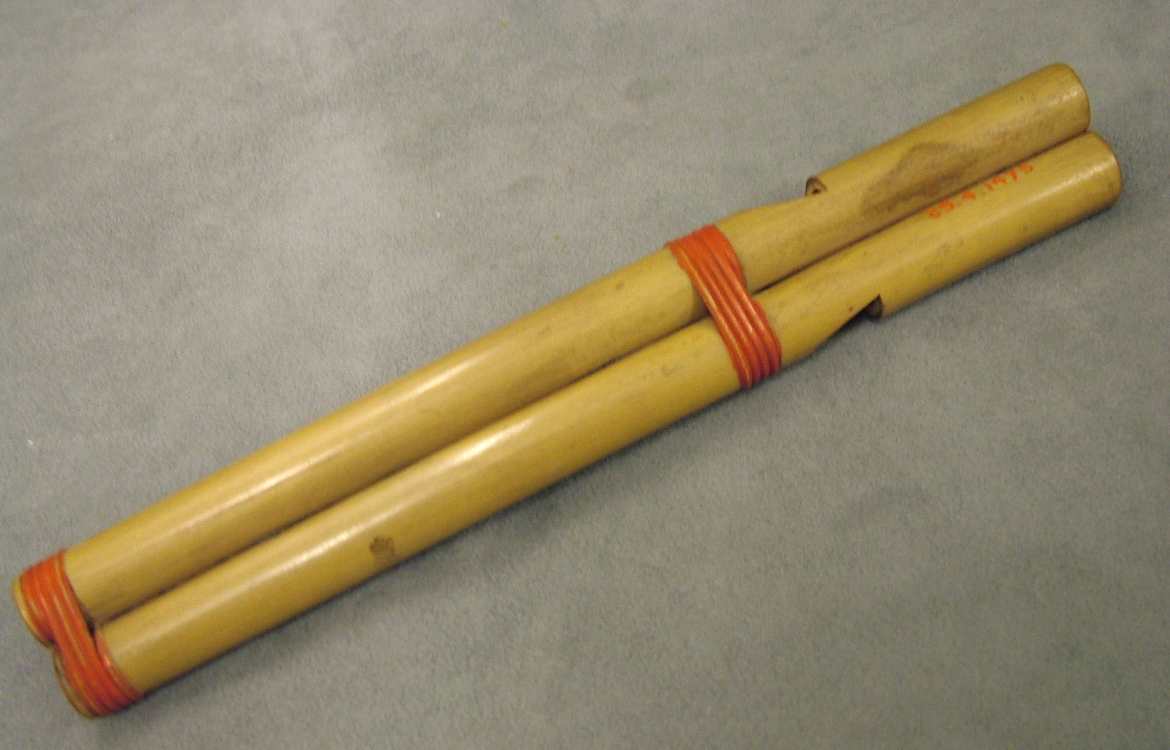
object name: amma no fue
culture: japanese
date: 1801-1900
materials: bamboo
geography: japan